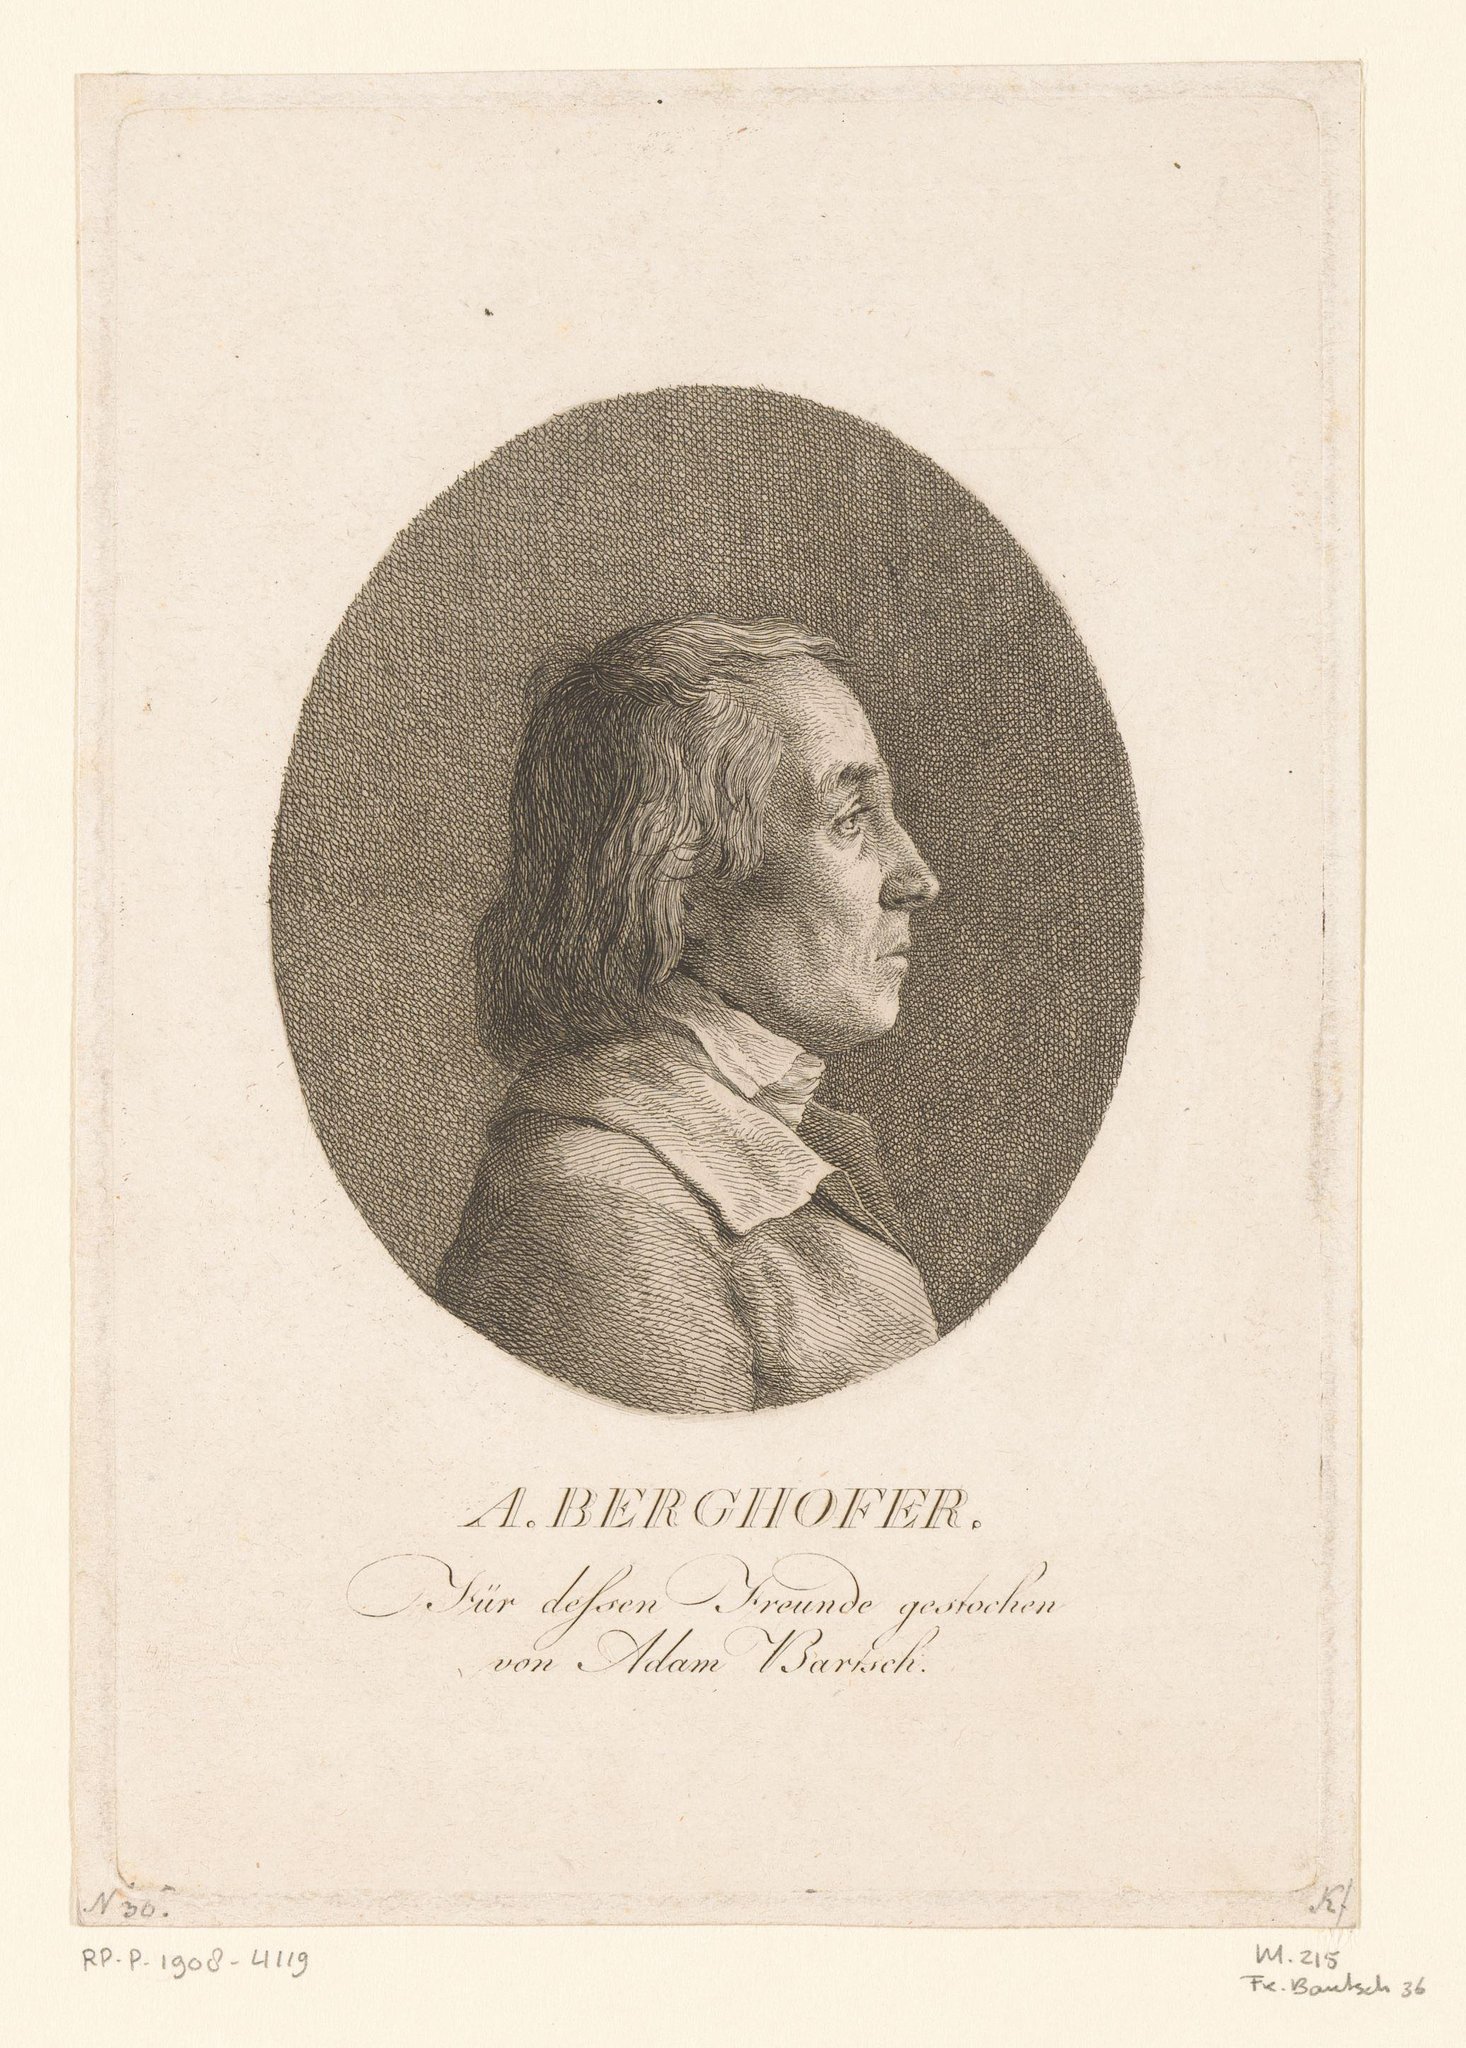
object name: print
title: Portret van Amand Berghofer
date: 1789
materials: paper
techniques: etching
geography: vienna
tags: amand berghofer, historical persons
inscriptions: collector's mark: Lugt 2228